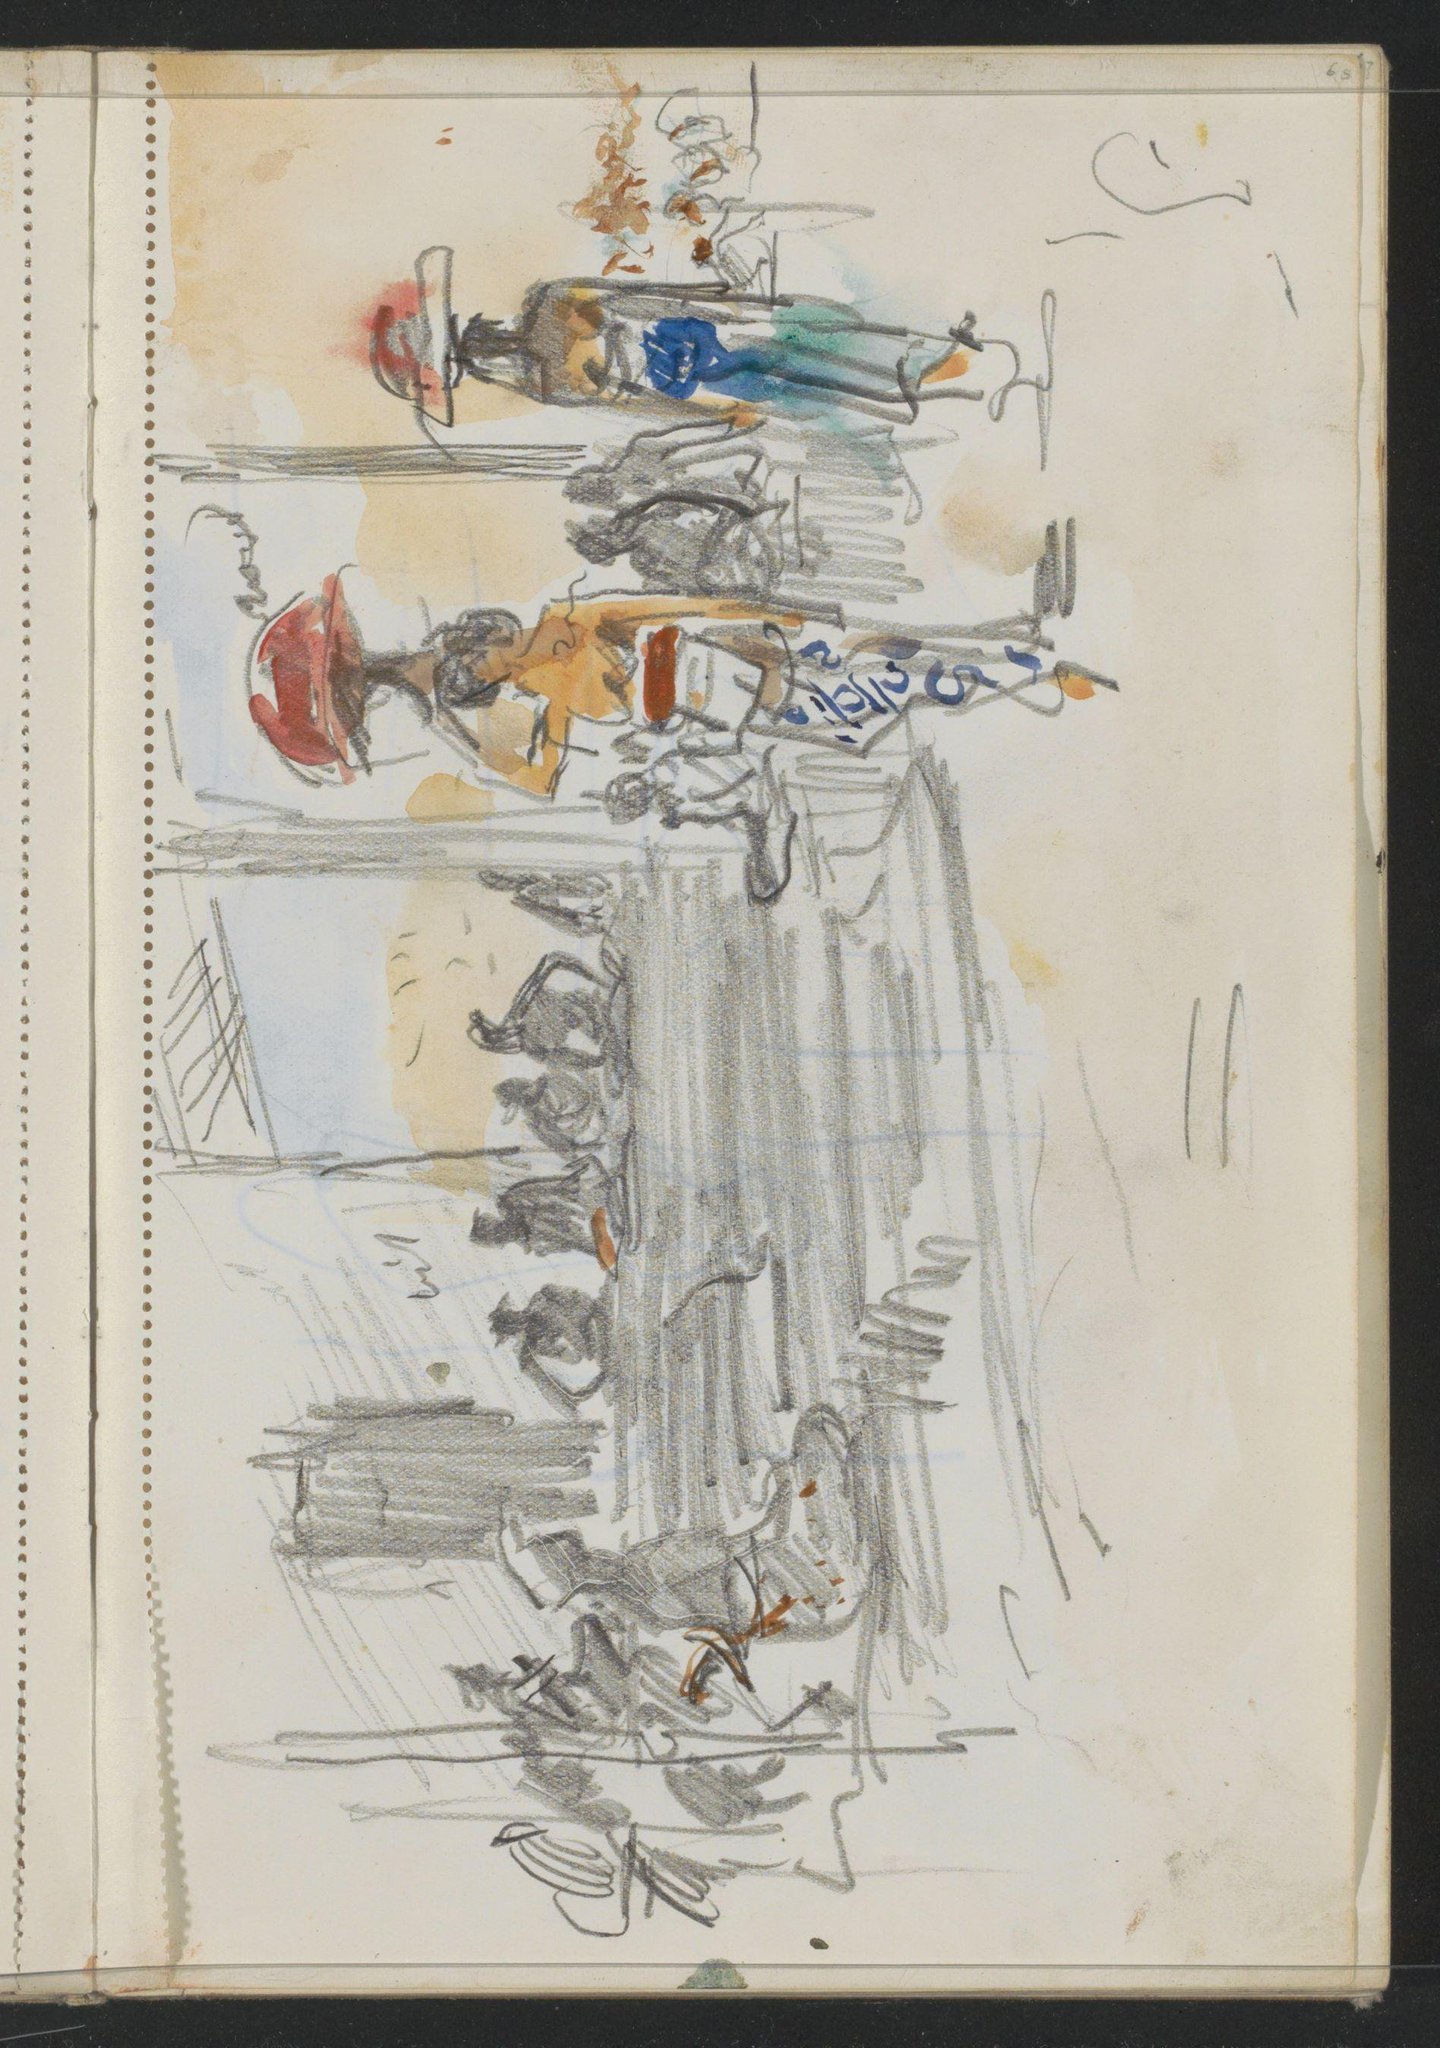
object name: sketchbook leaf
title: Straat met figuren op een trap en vrouwen met schalen op het hoofd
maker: marius bauer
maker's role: draughtsman, print maker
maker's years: 1867-1932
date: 1925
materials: paper, pencil, watercolor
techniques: brush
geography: indonesia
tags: flight of steps, folk costume, regional costume, carrying something on the head or on the shoulders, street (+ city(-scape) with figures, staffage)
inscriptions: kleurnotitie, handgeschreven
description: De figuren zitten op een trap onder een afdak, mogelijk de uitbouw van een gebouw. Pagina 65 uit een schetsboek met 74 bladen.